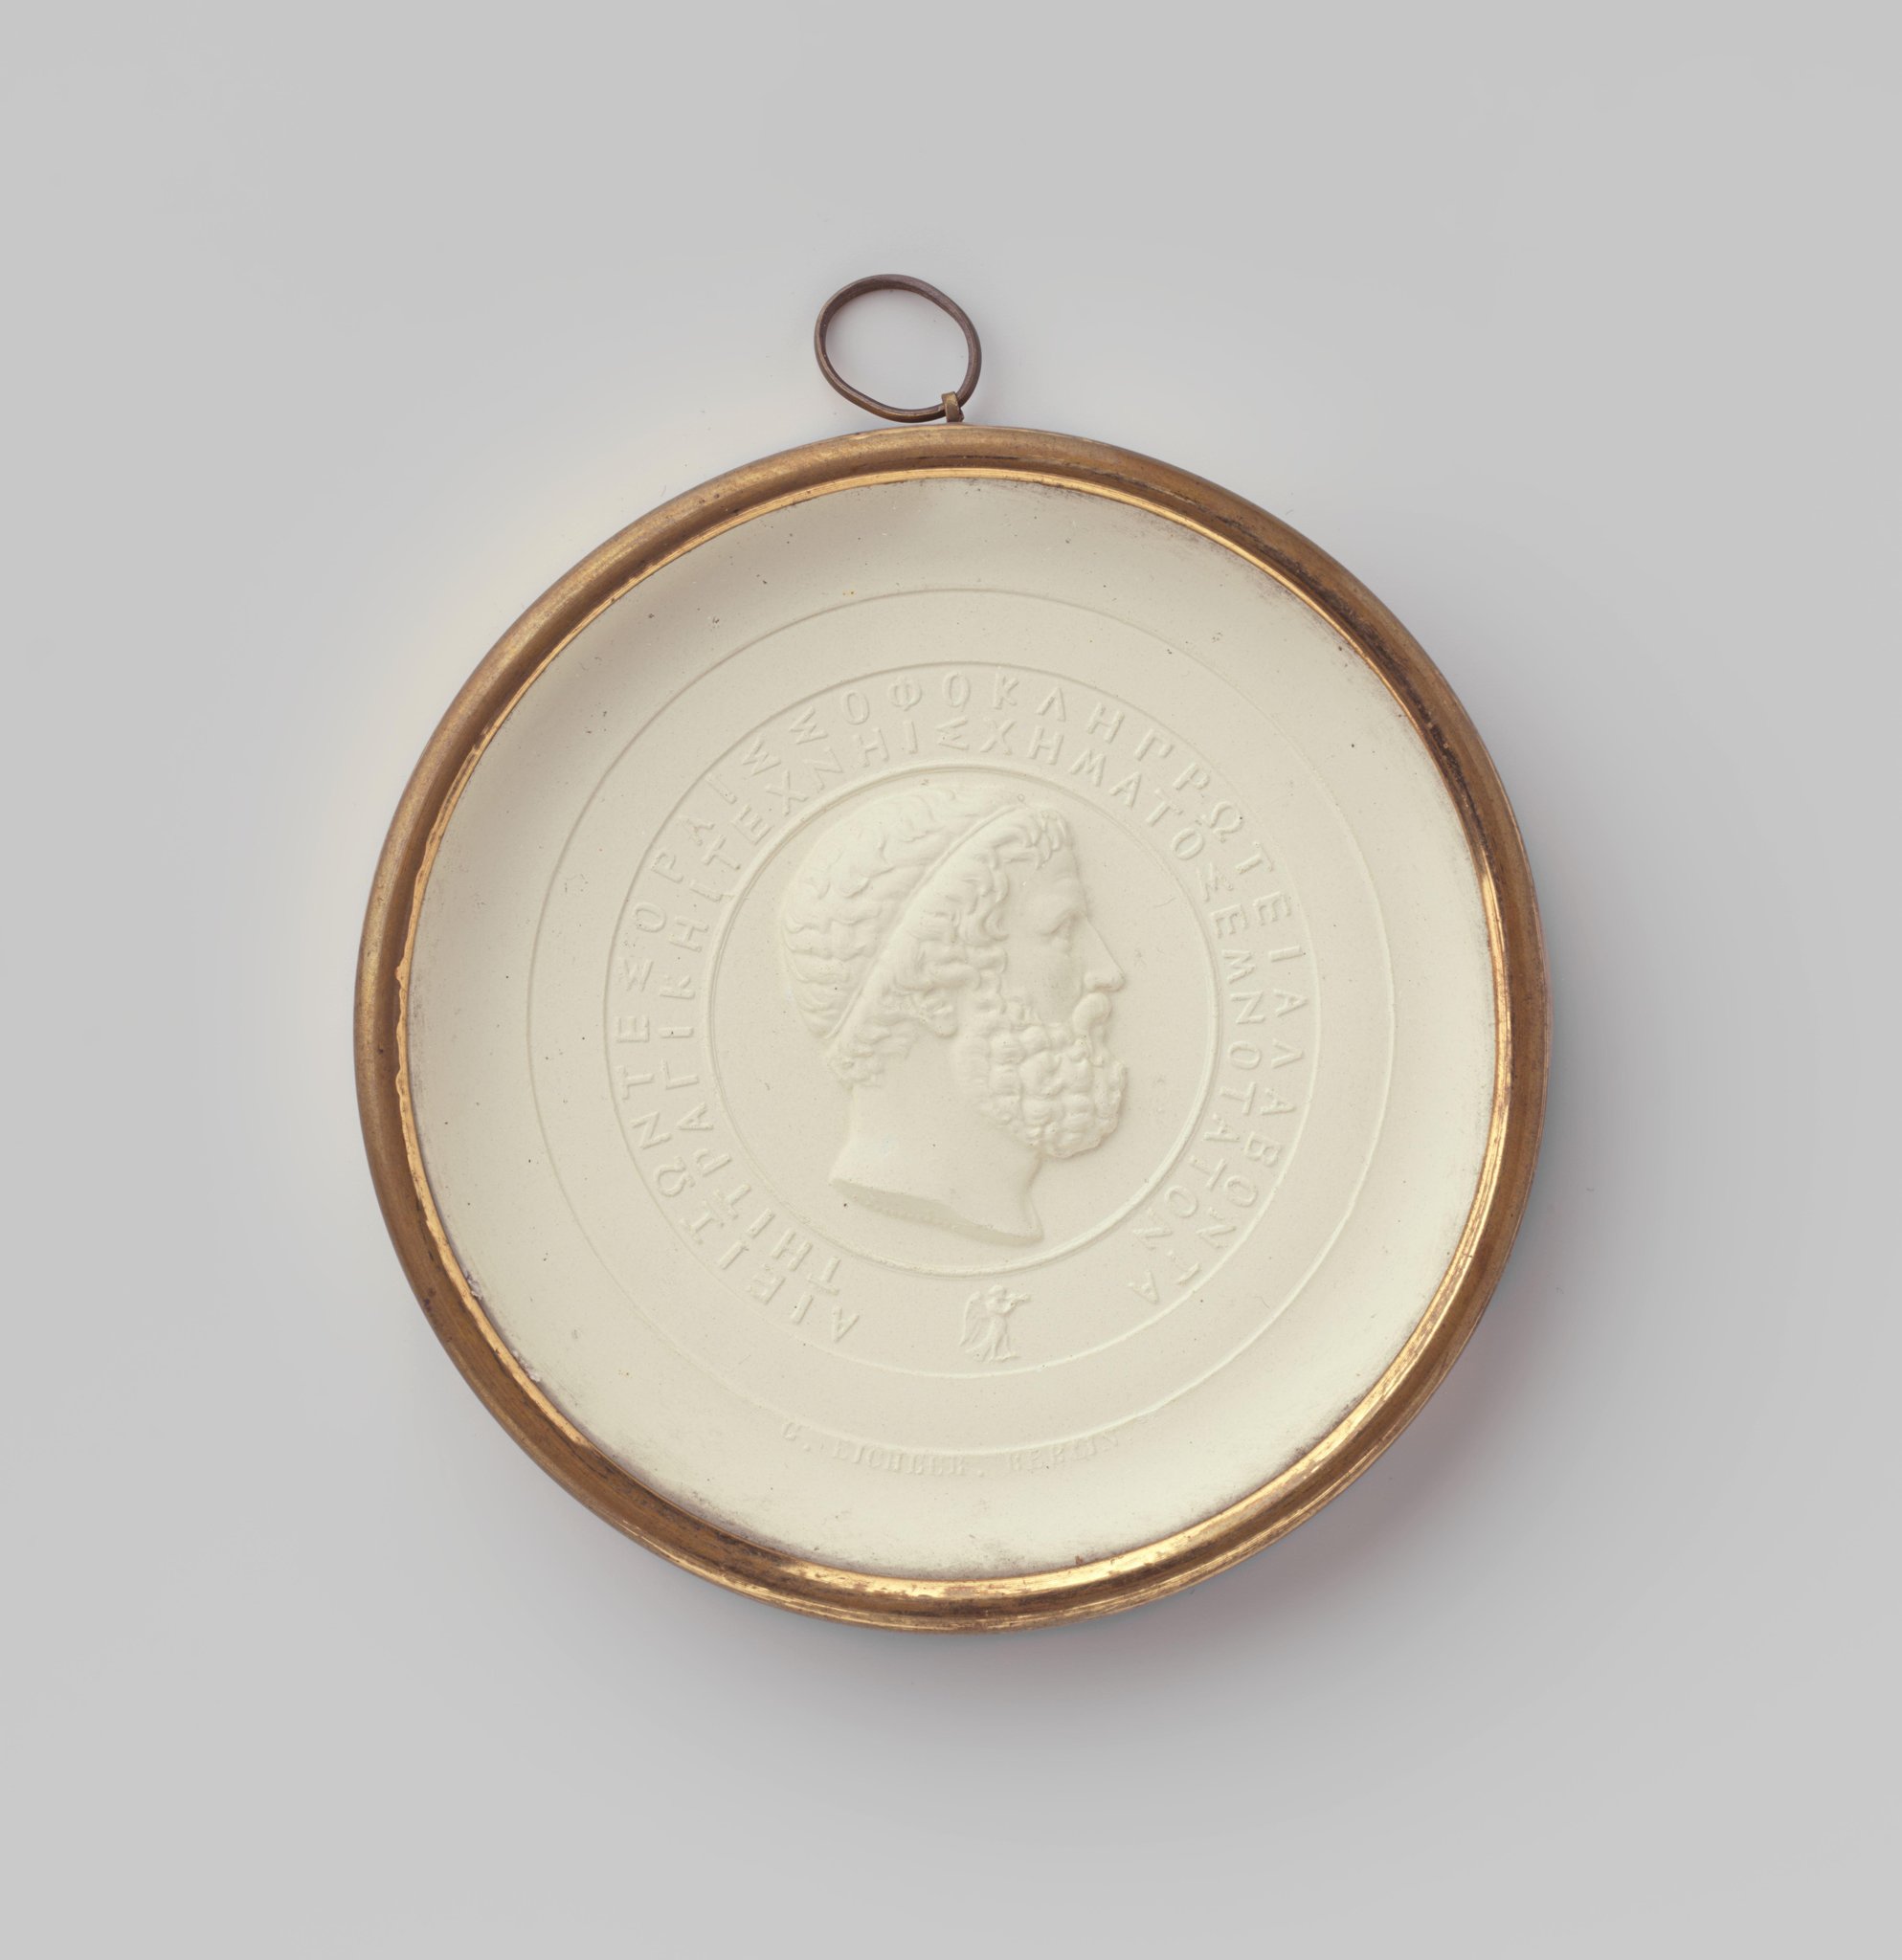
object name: locket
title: Sophocles, Grieks tragediedichter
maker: gottfried eichler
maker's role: draughtsman, painter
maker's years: 1677-1757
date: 1687-1757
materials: brass, glass, gypsum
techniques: casting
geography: berlin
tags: sophocles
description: Eenzijdig medaillon in messing ring achter glas aan draagoog en draagring. Voorzijde: borststuk man met baard en krans in haar binnen tweeregelig omschrift in Grieks.